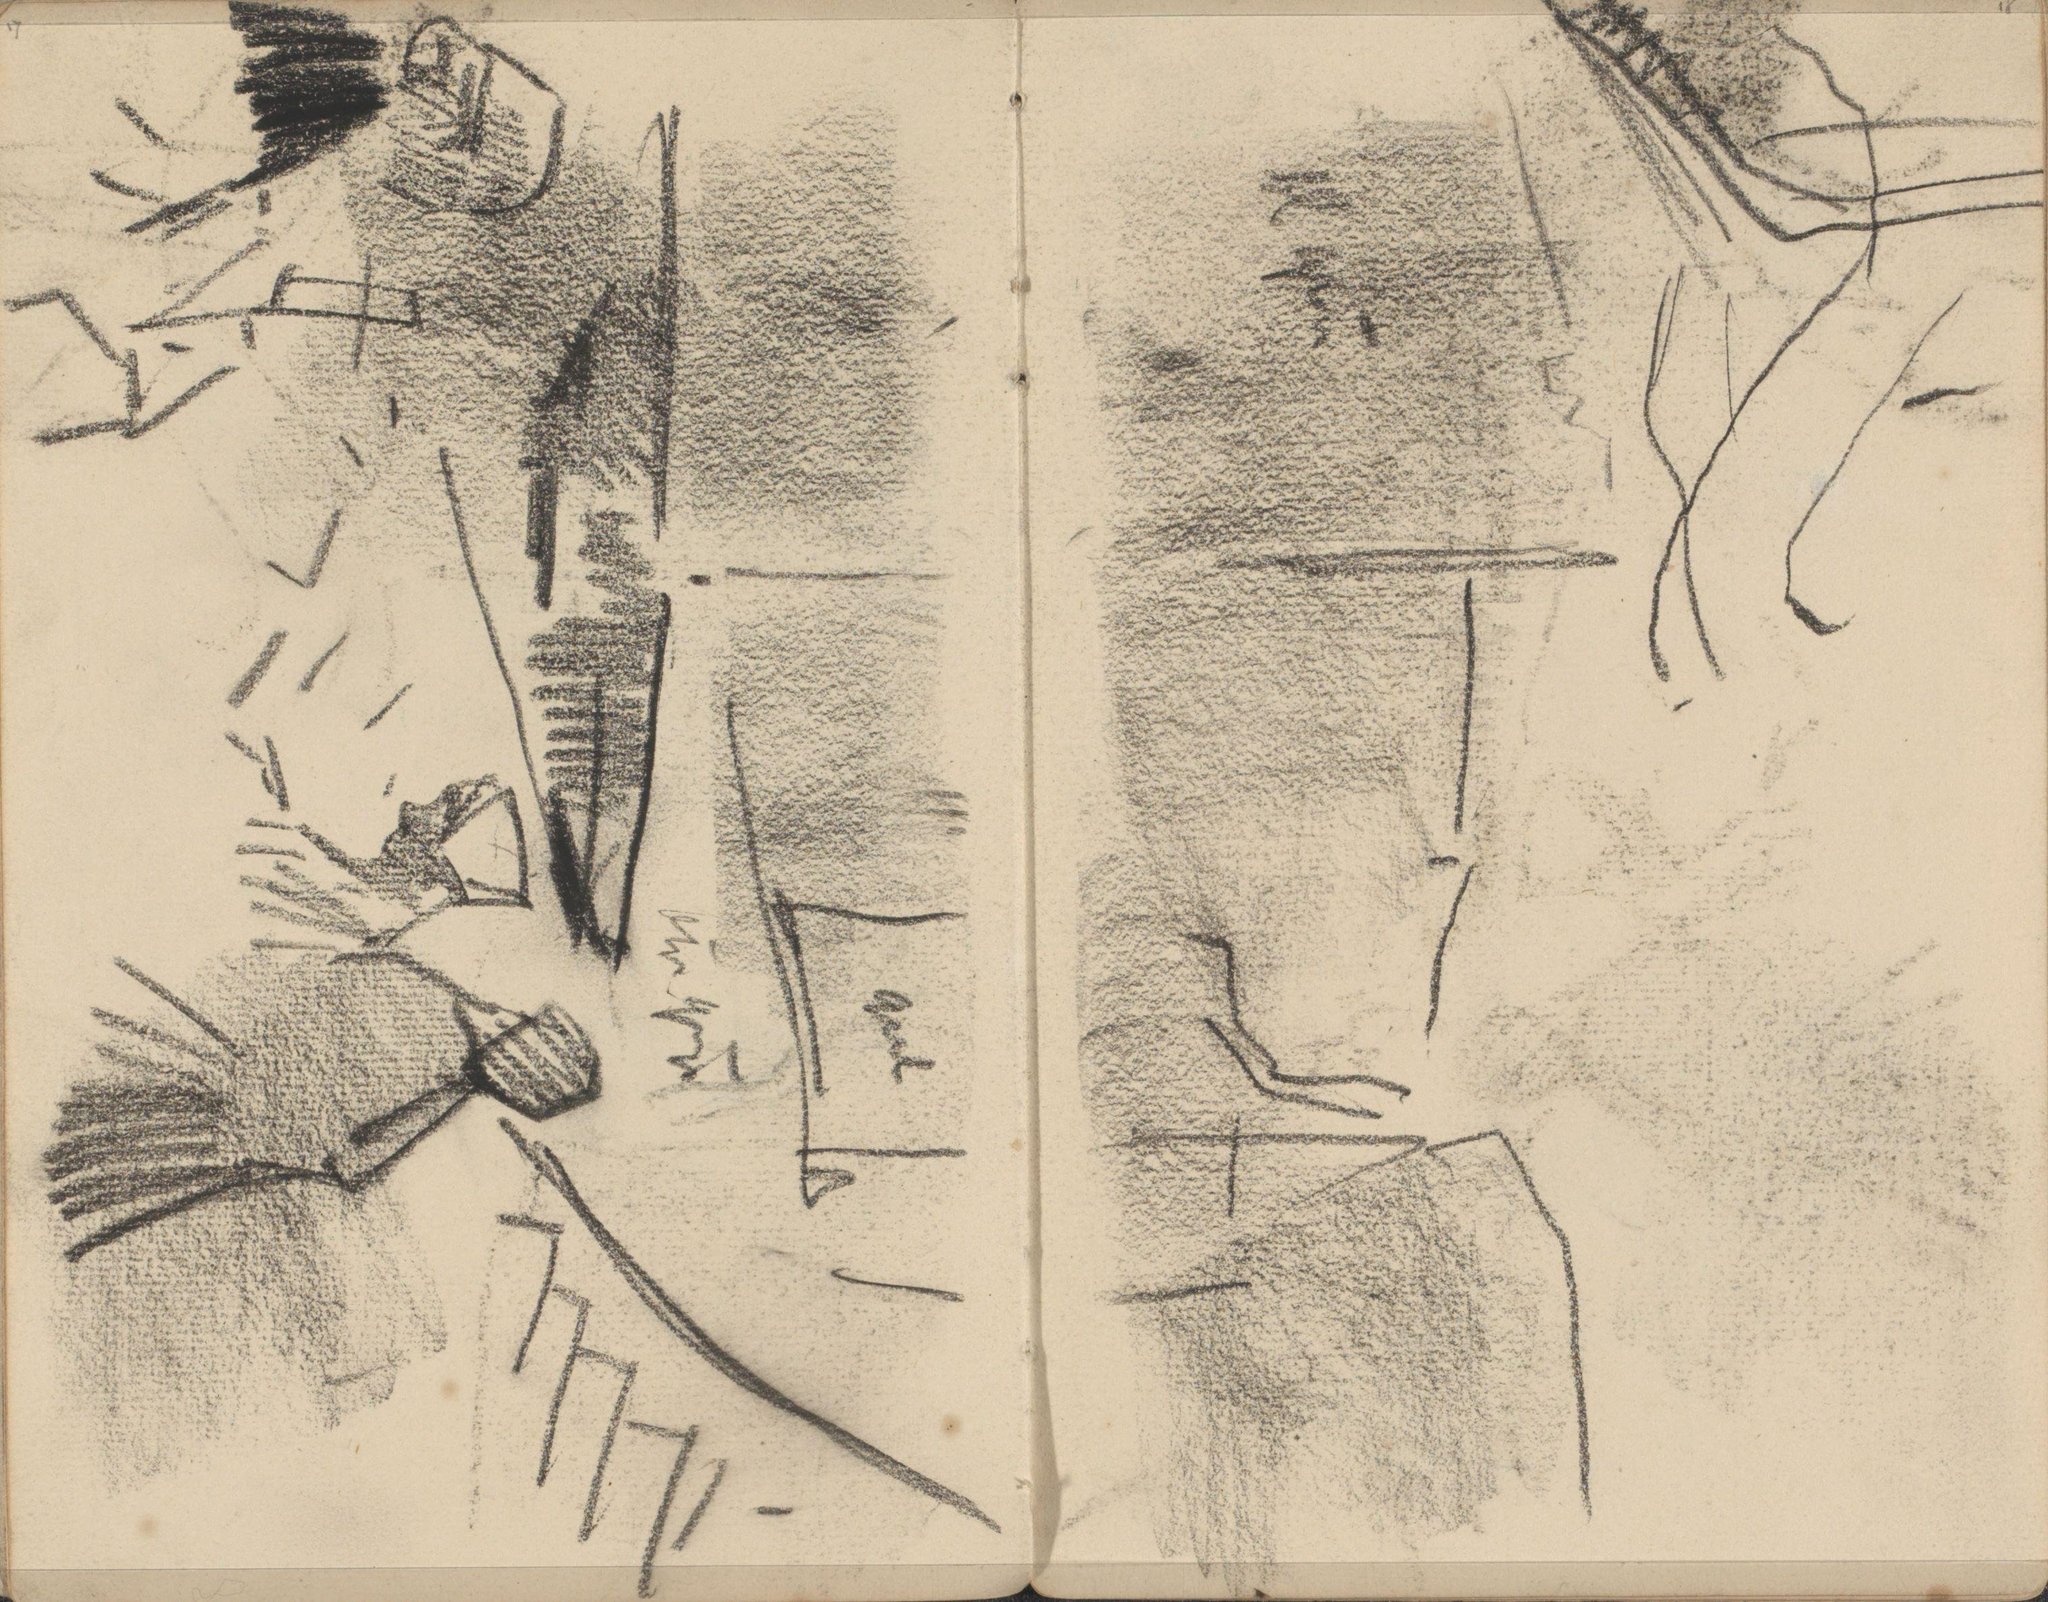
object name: sketchbook leaf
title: Vrouwen voor gebouwen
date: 1884-1886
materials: chalk, paper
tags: adult woman, civic architecture; edifices; dwellings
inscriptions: kleurnotitie, handgeschreven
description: Pagina 17 en pagina 18 uit een schetsboek met 16 bladen.